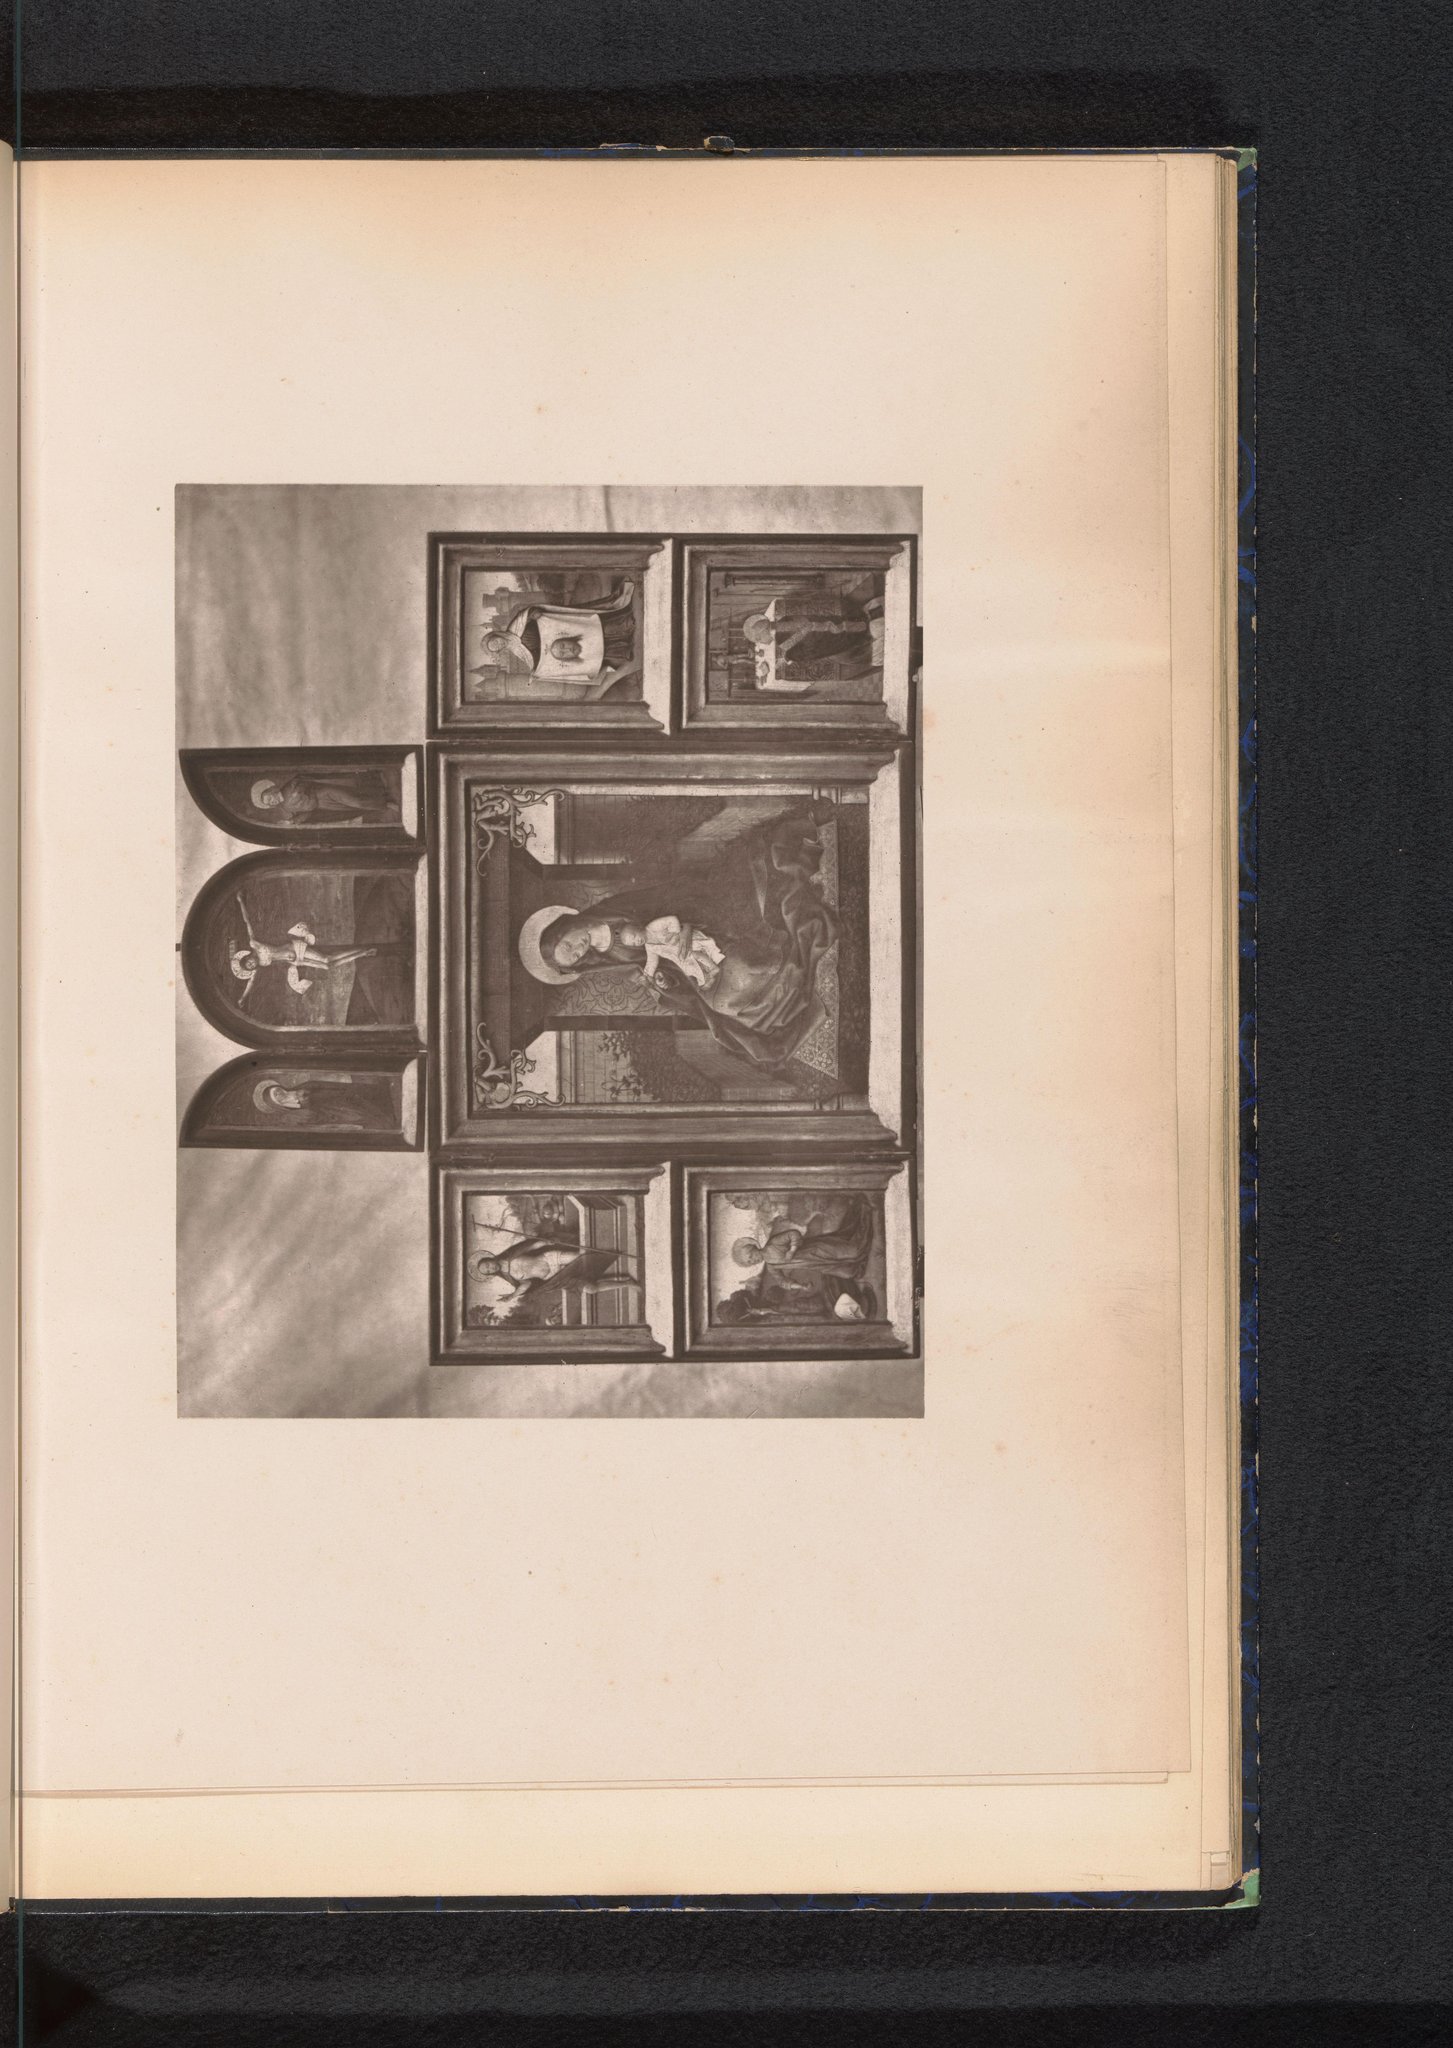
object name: reproduction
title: Reproductie van een geschilderd triptiek met voorstellingen uit de Passie van Christus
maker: Anonymous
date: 1878-1883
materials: paper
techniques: woodburytype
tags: mary sitting or enthroned, the christ-child in front of her, sitting in her lap (or in front of her bosom), passion of christ